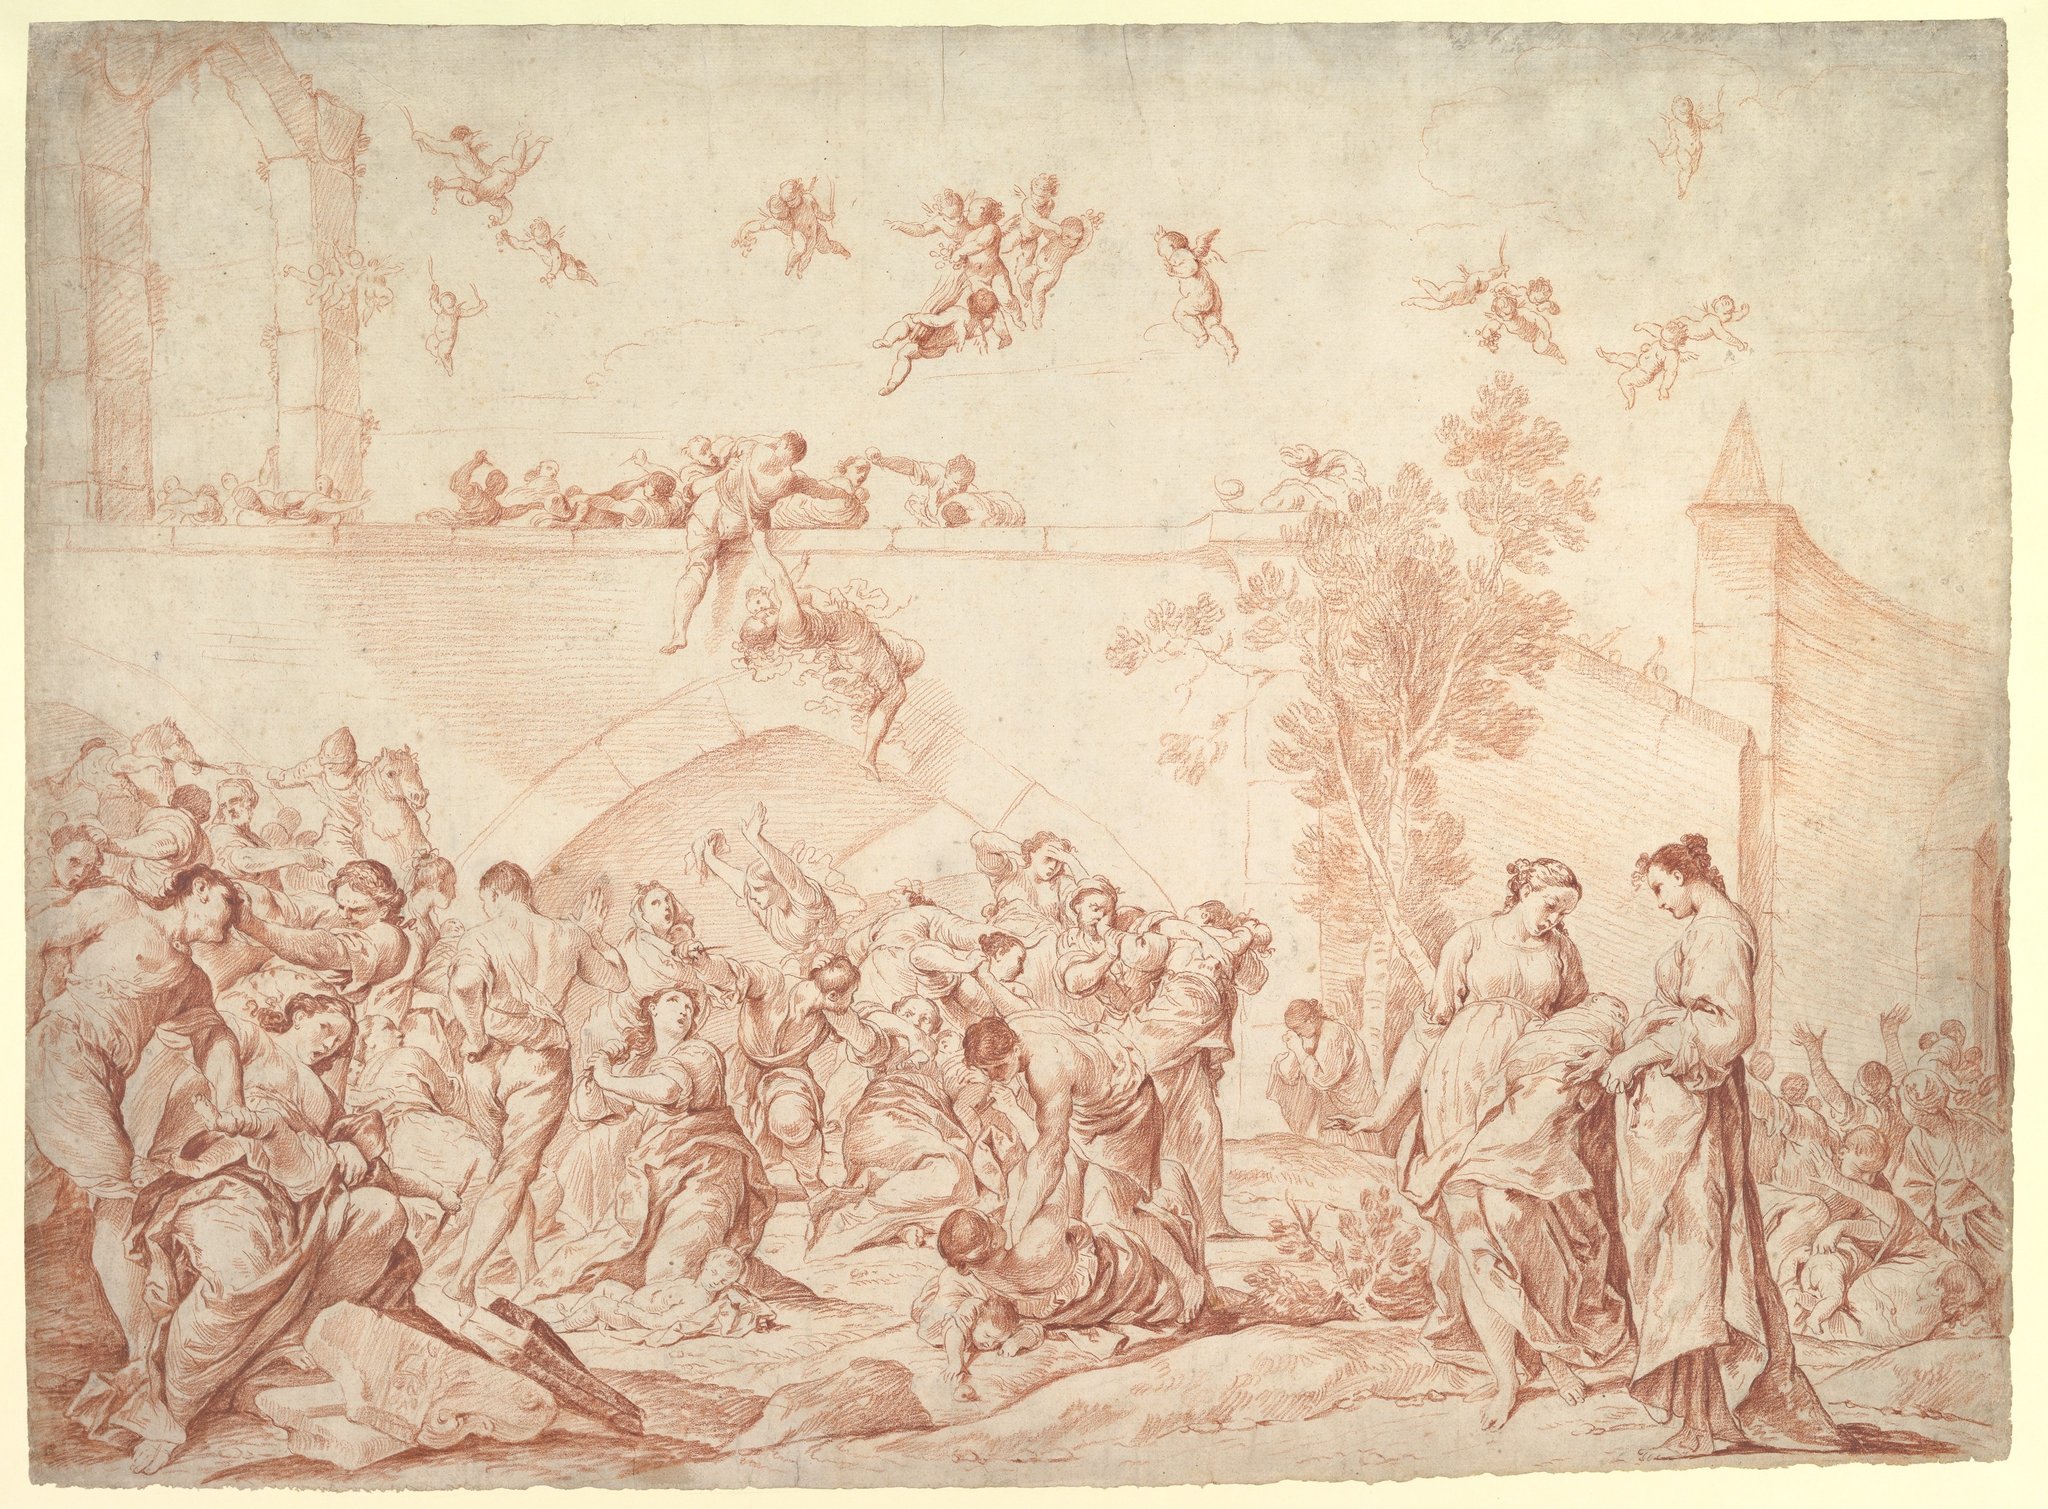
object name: drawing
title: The Massacre of the Innocents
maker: giuseppe maria crespi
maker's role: artist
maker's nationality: italian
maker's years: 1665-1747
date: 1665-1747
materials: chalk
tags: massacres,men,women